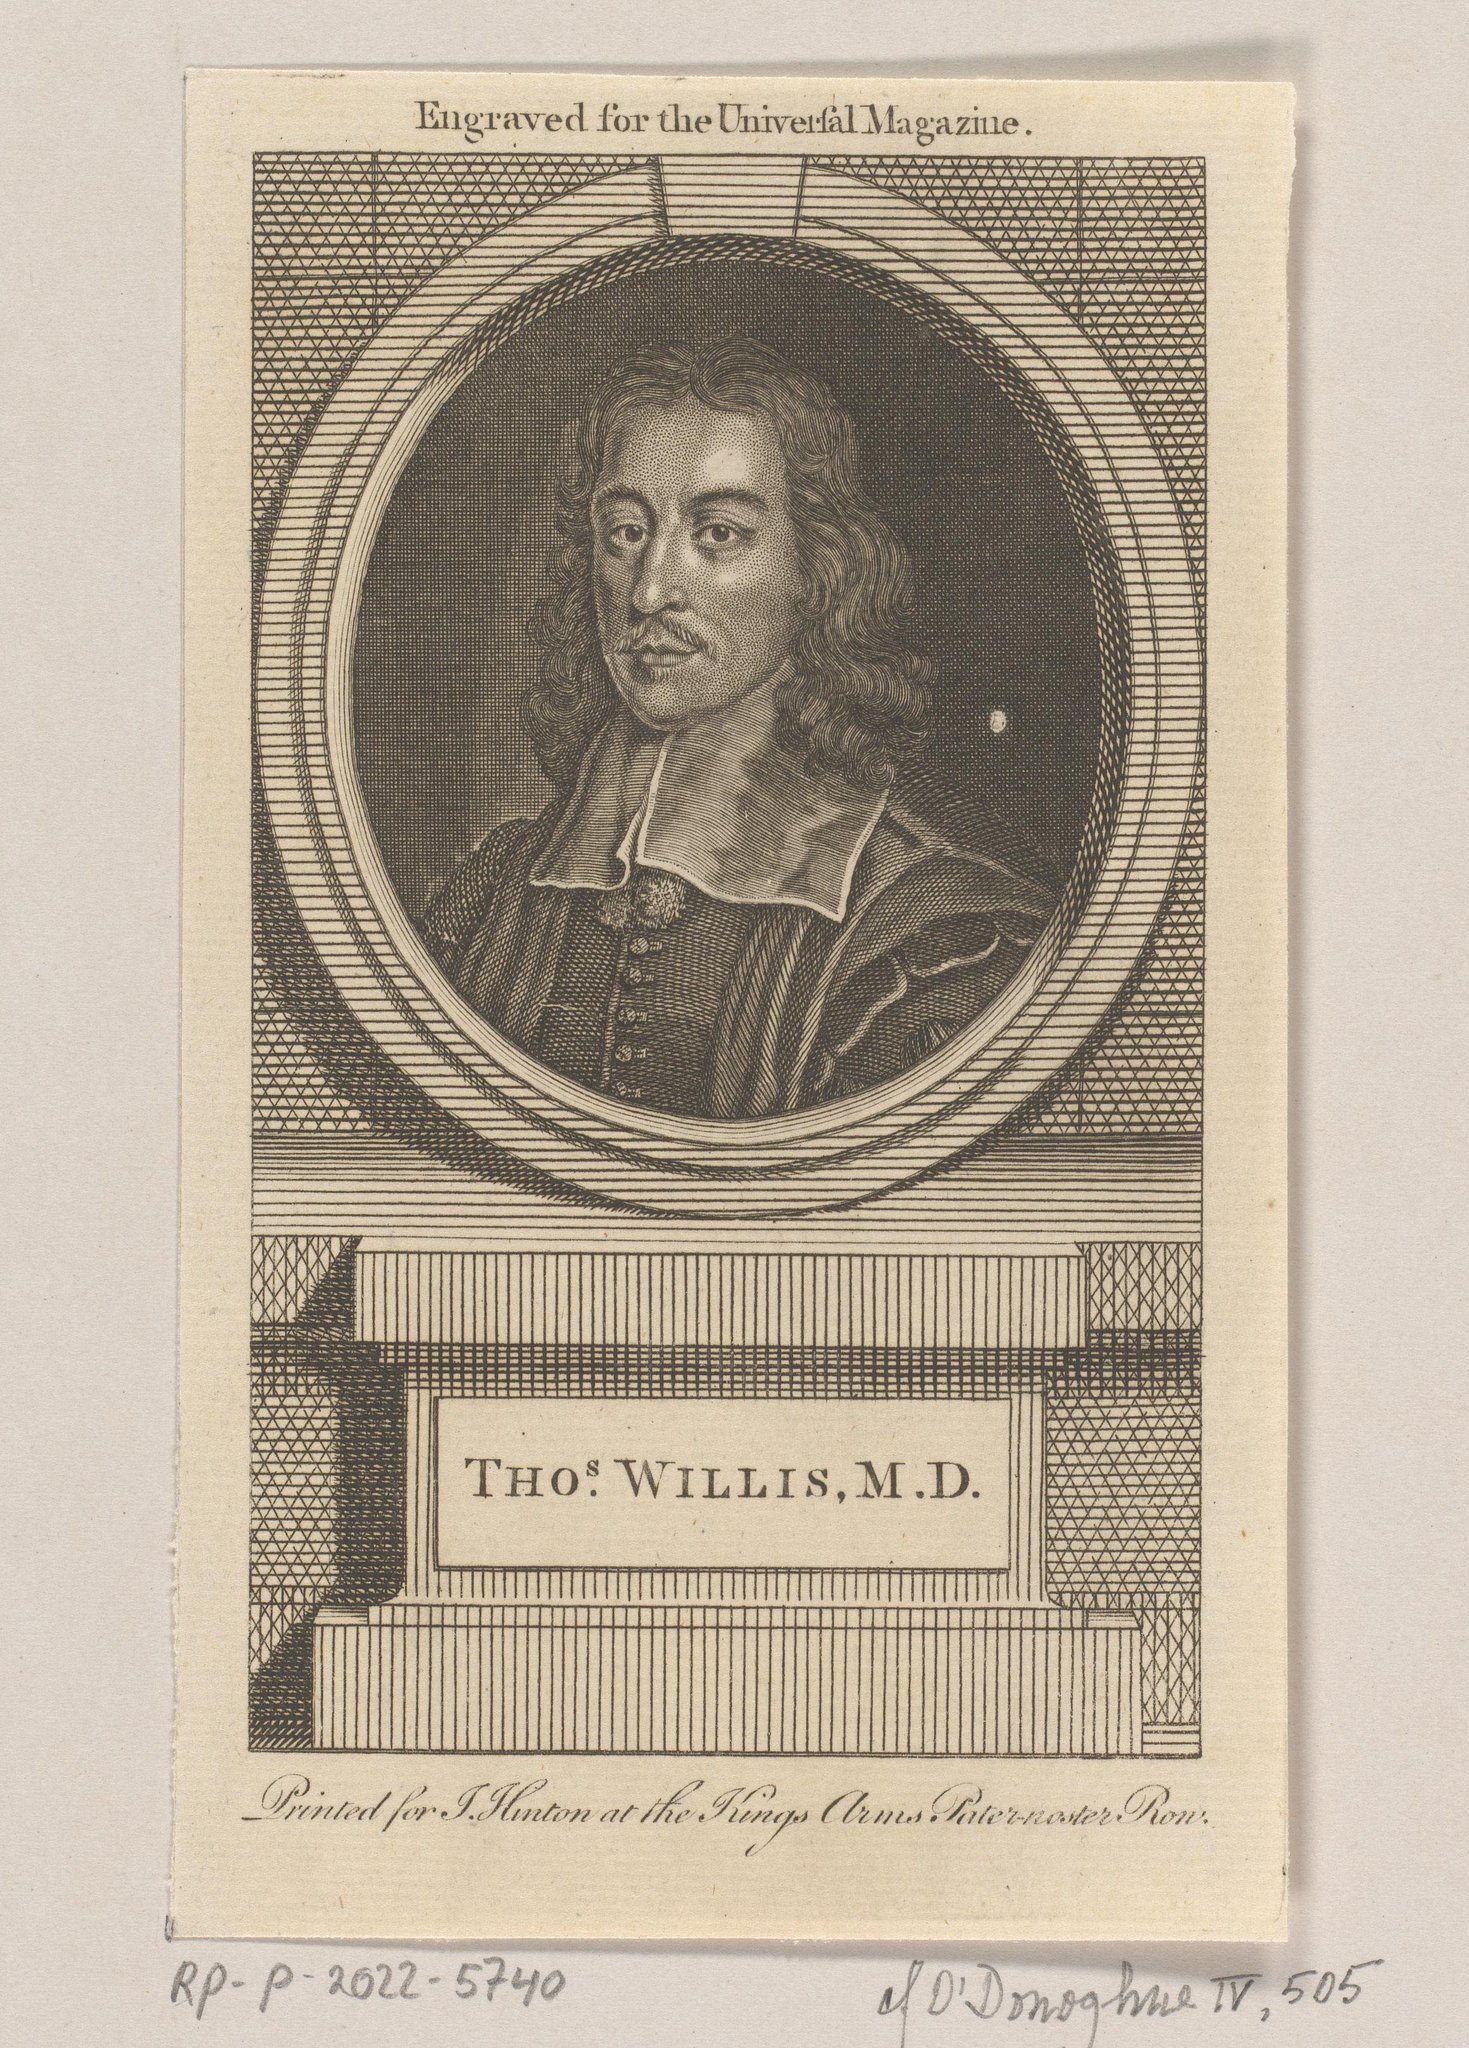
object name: print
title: Portret van Thomas Willis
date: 1768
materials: paper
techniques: engraving, etching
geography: london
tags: london, historical persons, physician, doctor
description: Bovenschrift: Engraved for the Universal Magazine. Onderschrift: Printed for J. Hinton at the Kings Arms Pater-noster Row.